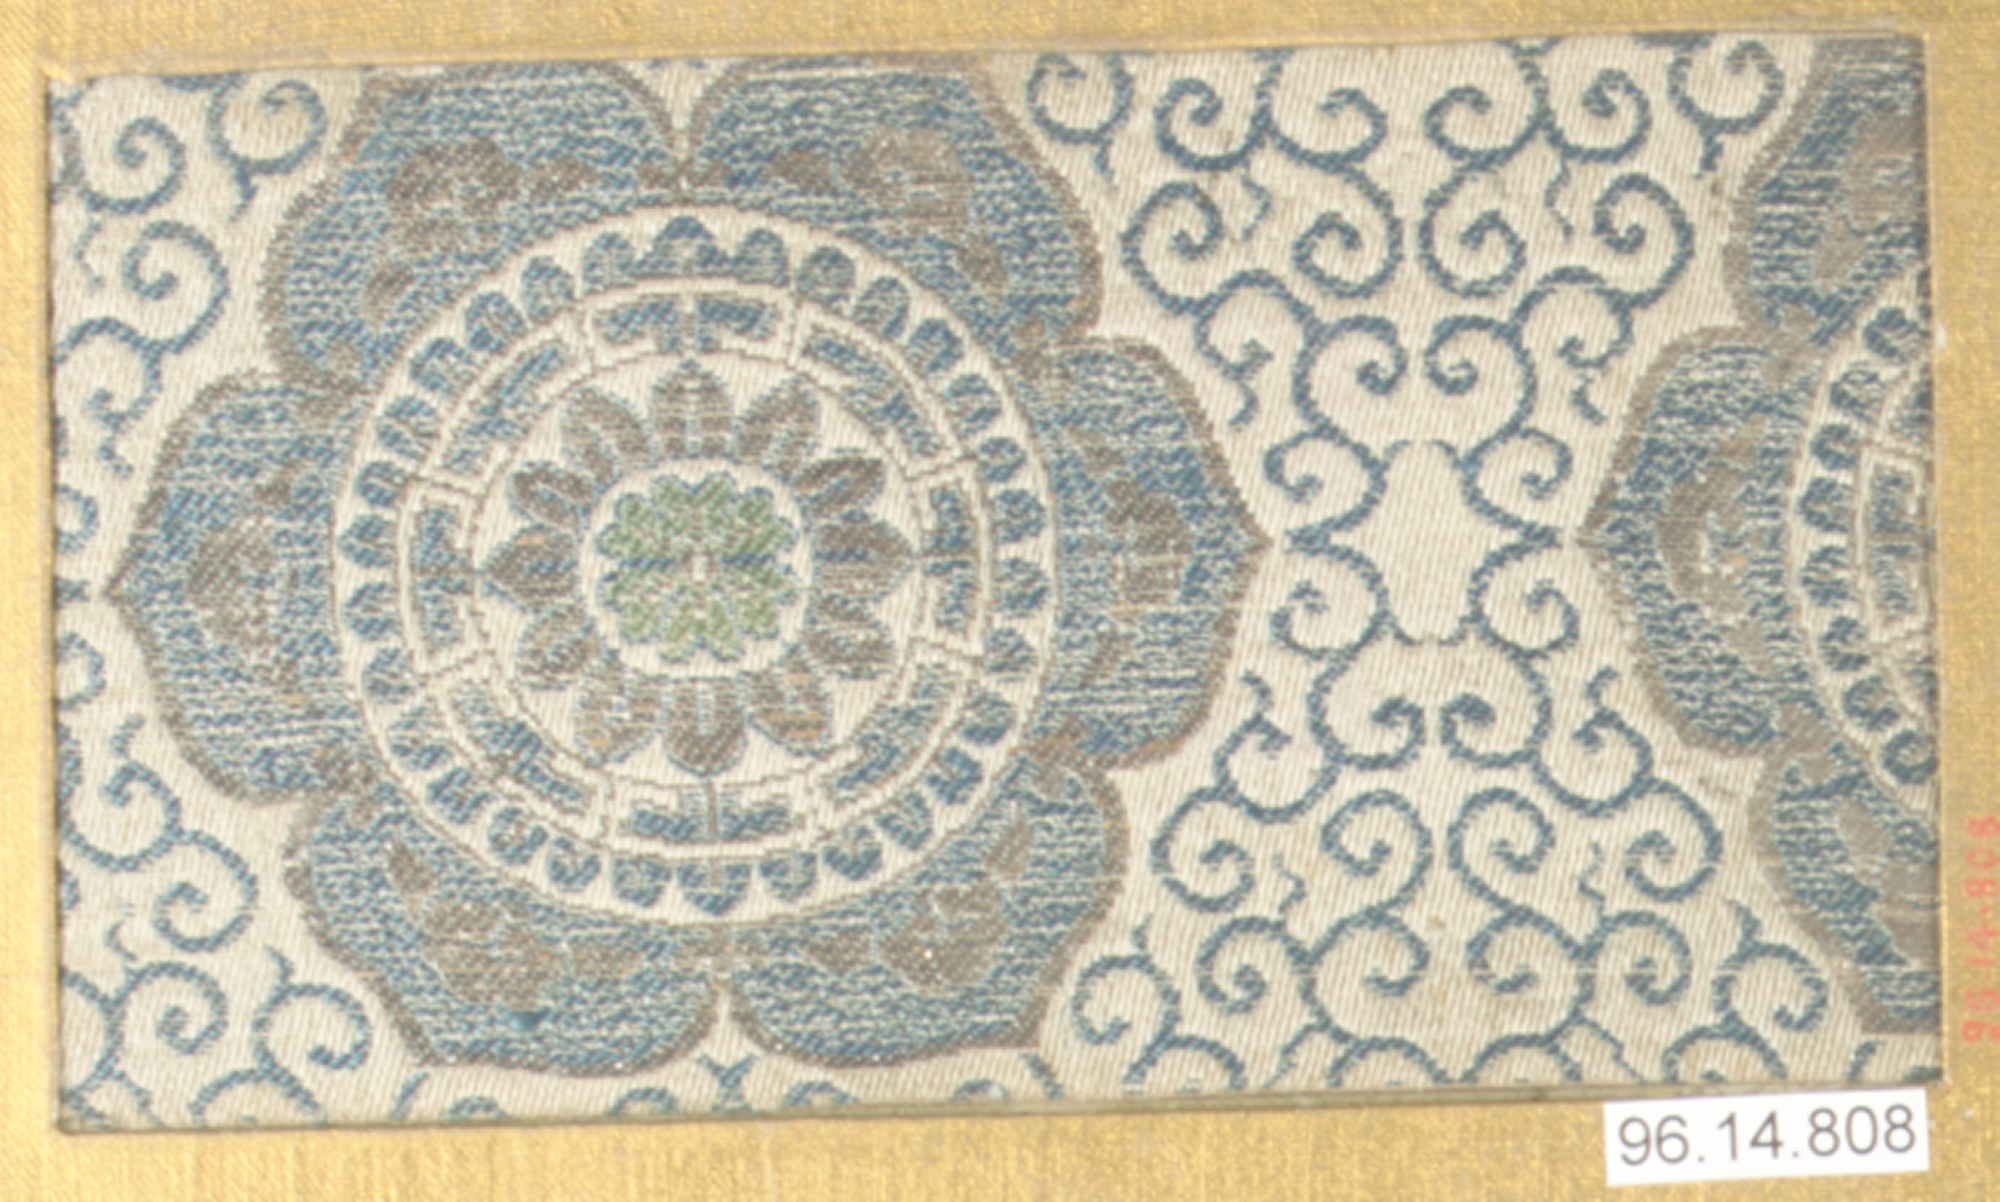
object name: piece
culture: japanese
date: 1701-1900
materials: silk